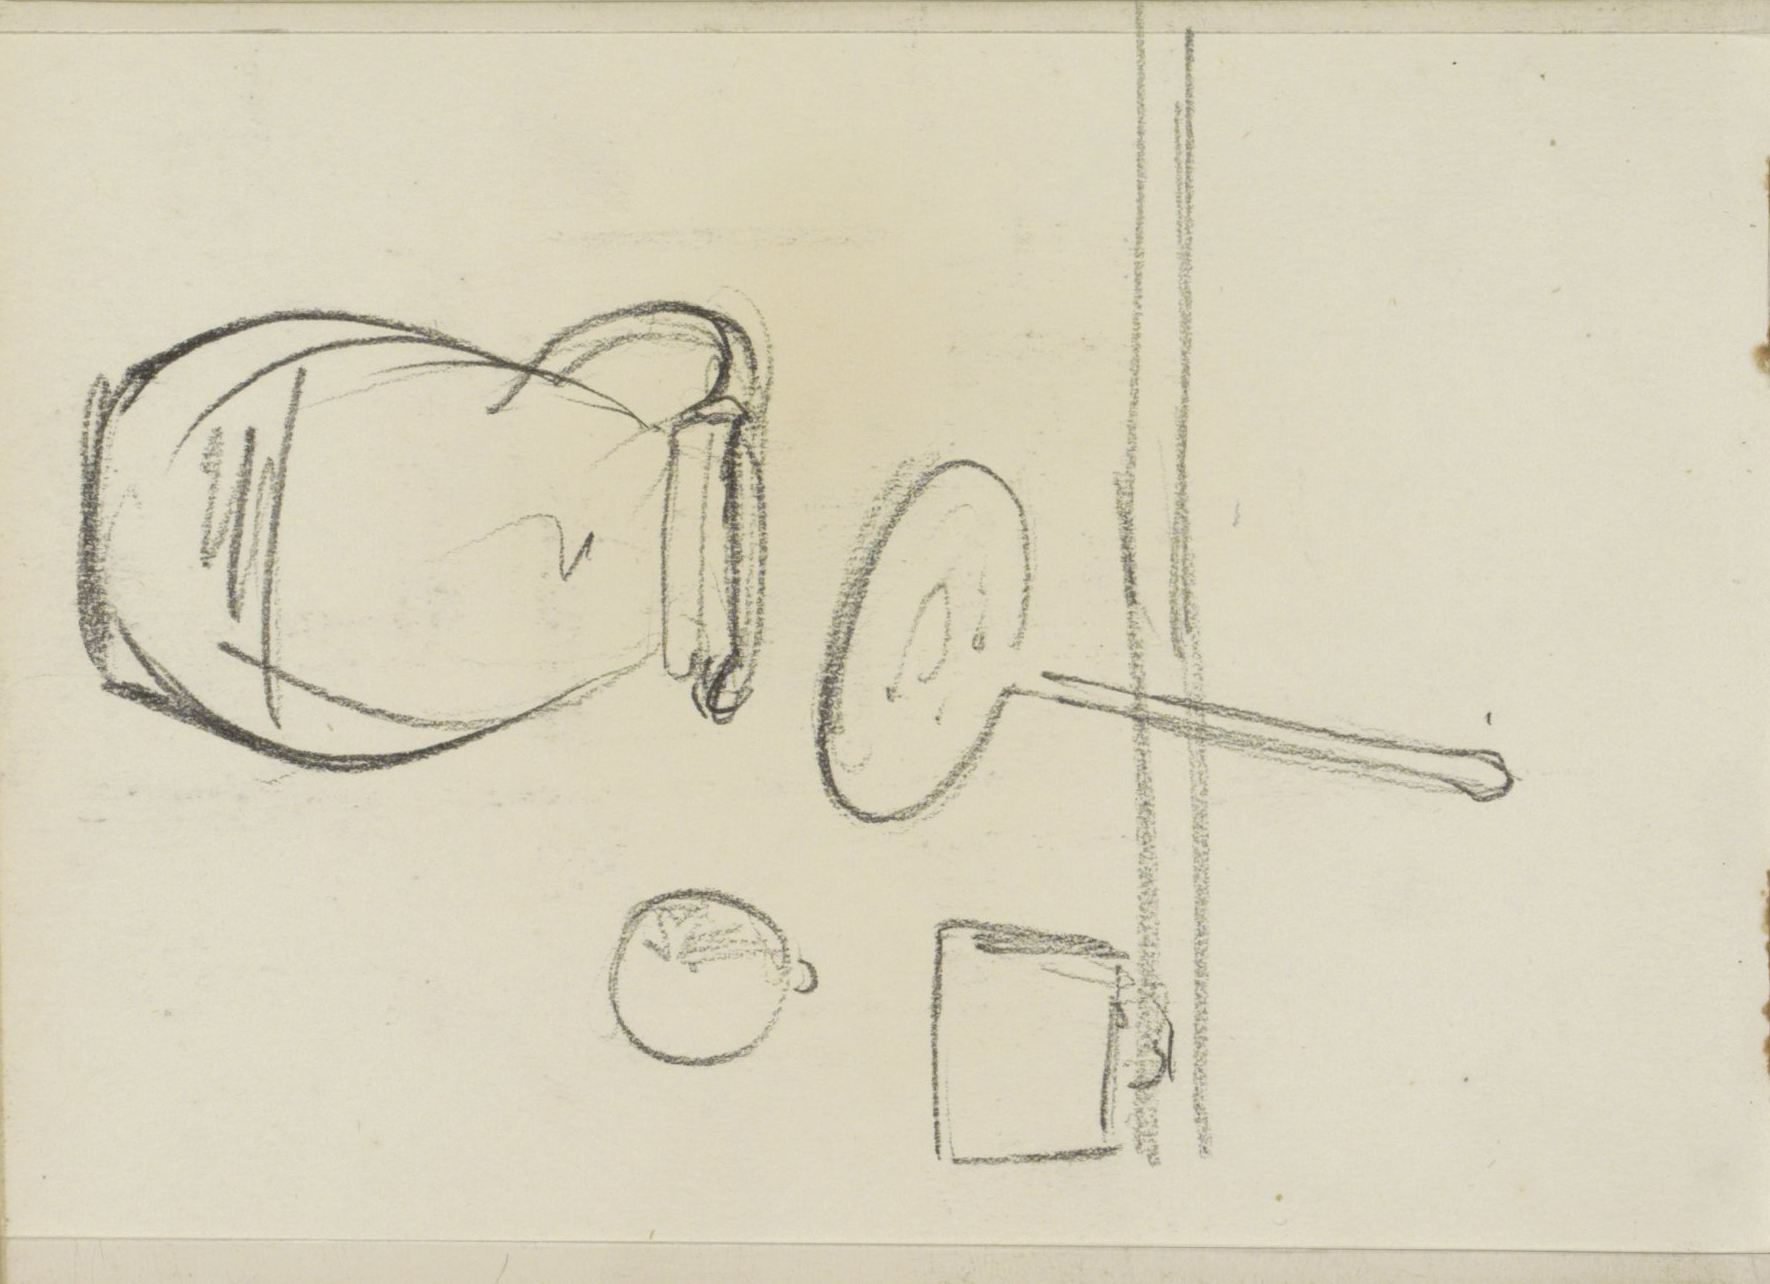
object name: sketchbook leaf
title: Tafel, onder andere met een kan en lepel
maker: a.a.l. de grammont-hubrecht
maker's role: draughtsman, painter, print maker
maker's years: 1855-1913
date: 1865-1913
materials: chalk, paper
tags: jar, jug (used as drinking-vessel), table, spoon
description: Blad 3 verso uit een schetsboek met 38 bladen.